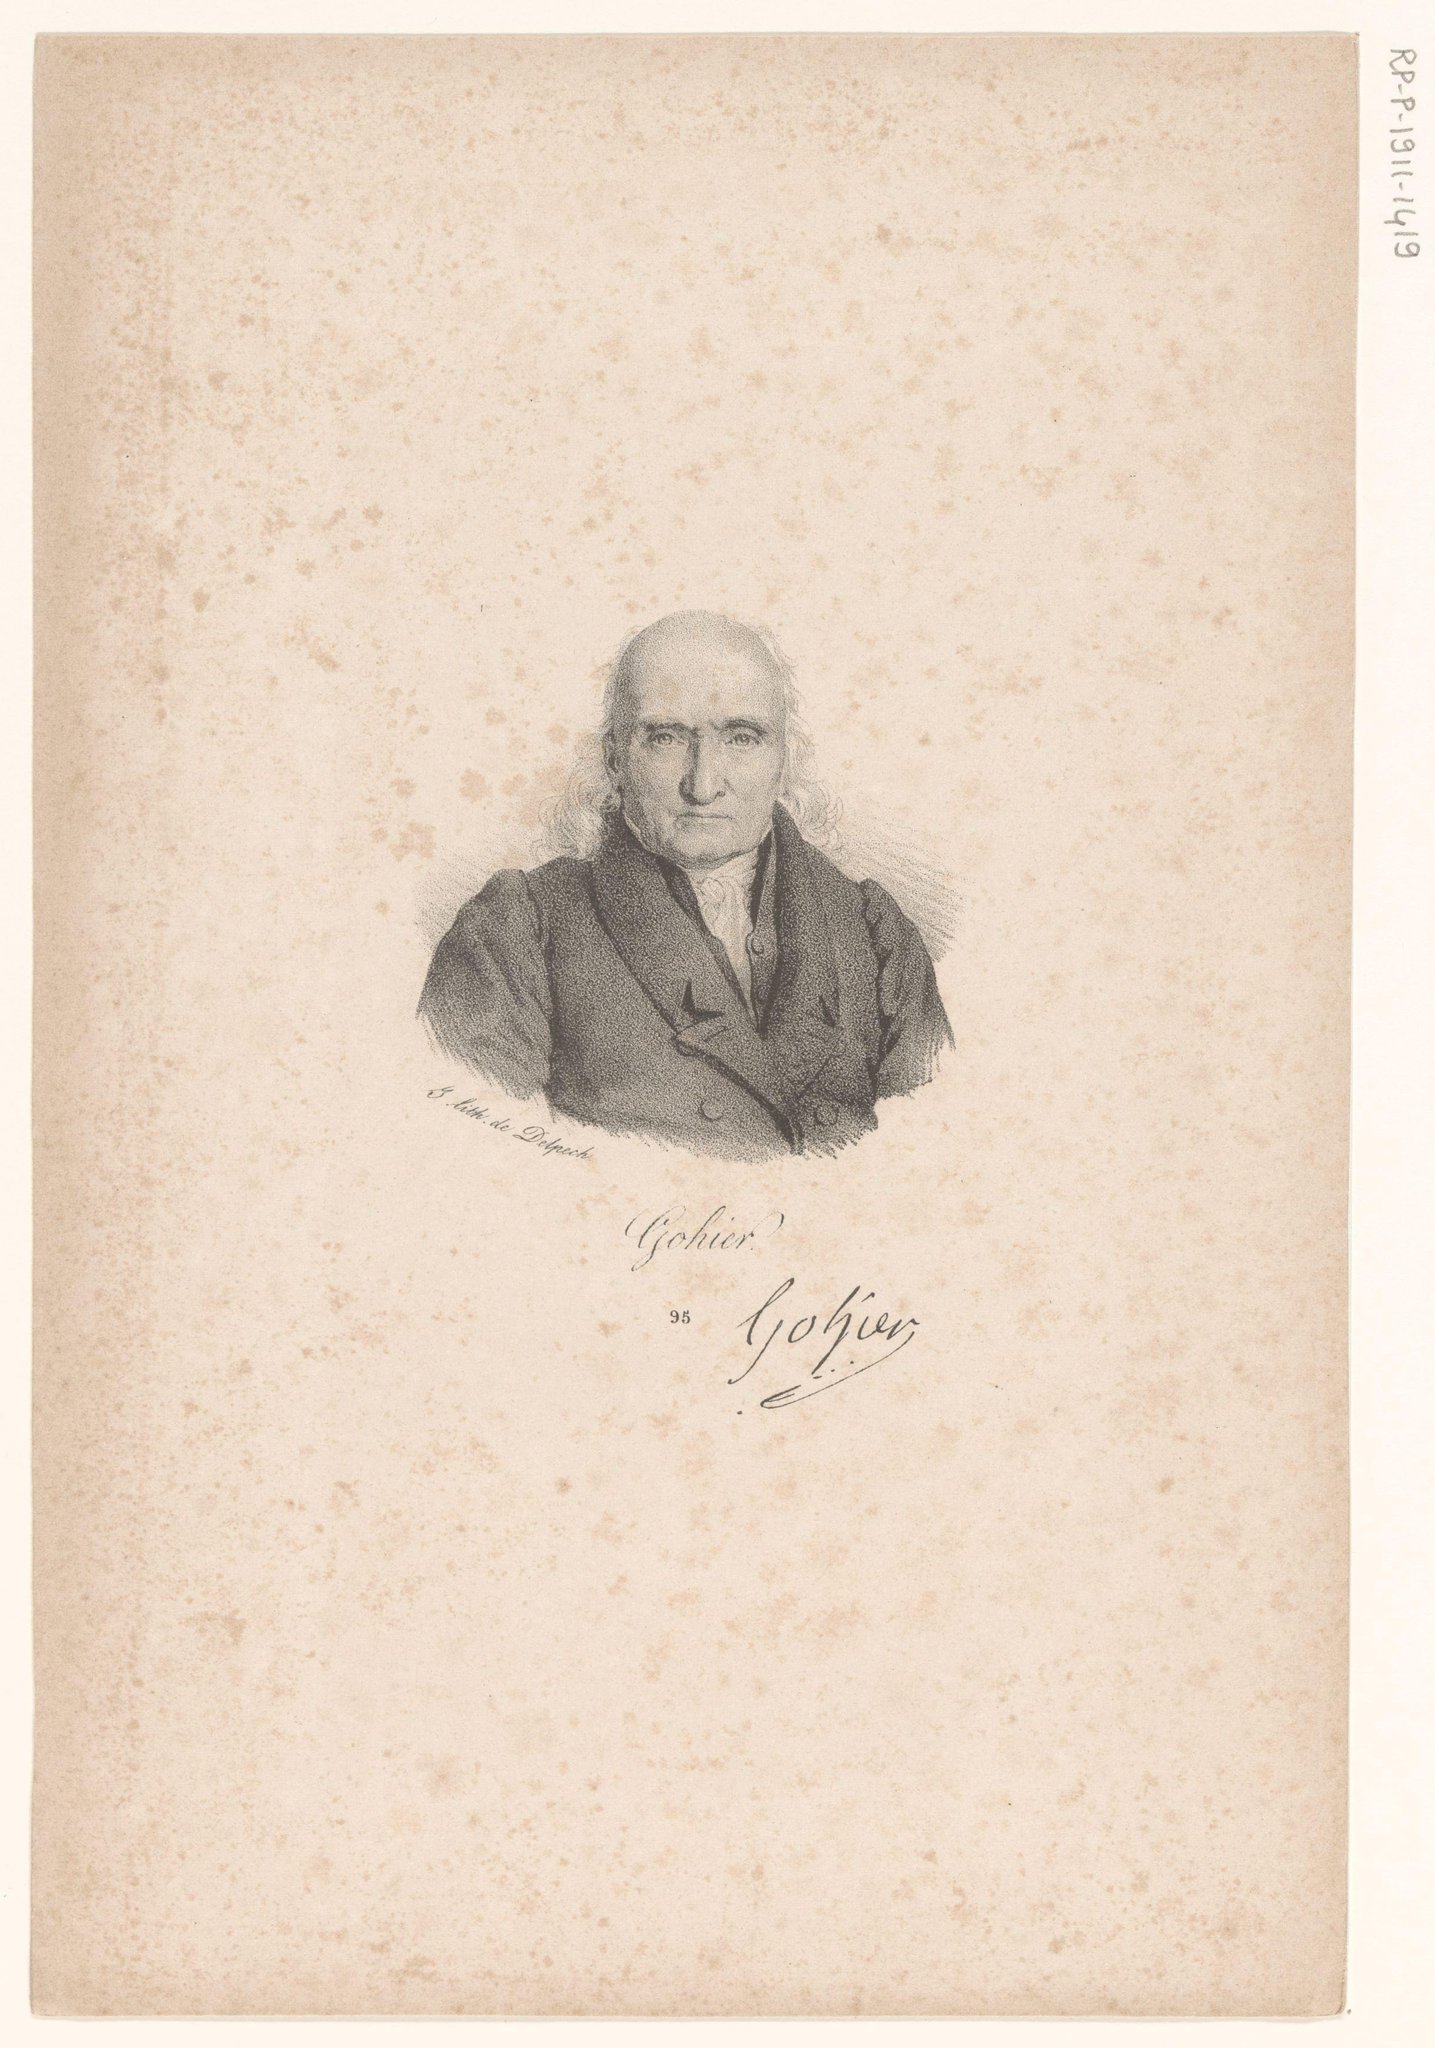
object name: print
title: Portret van Louis-Jérôme Gohier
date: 1818-1842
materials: paper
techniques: lithograph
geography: paris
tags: politician, historical persons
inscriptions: collector's mark: Lugt 2228a